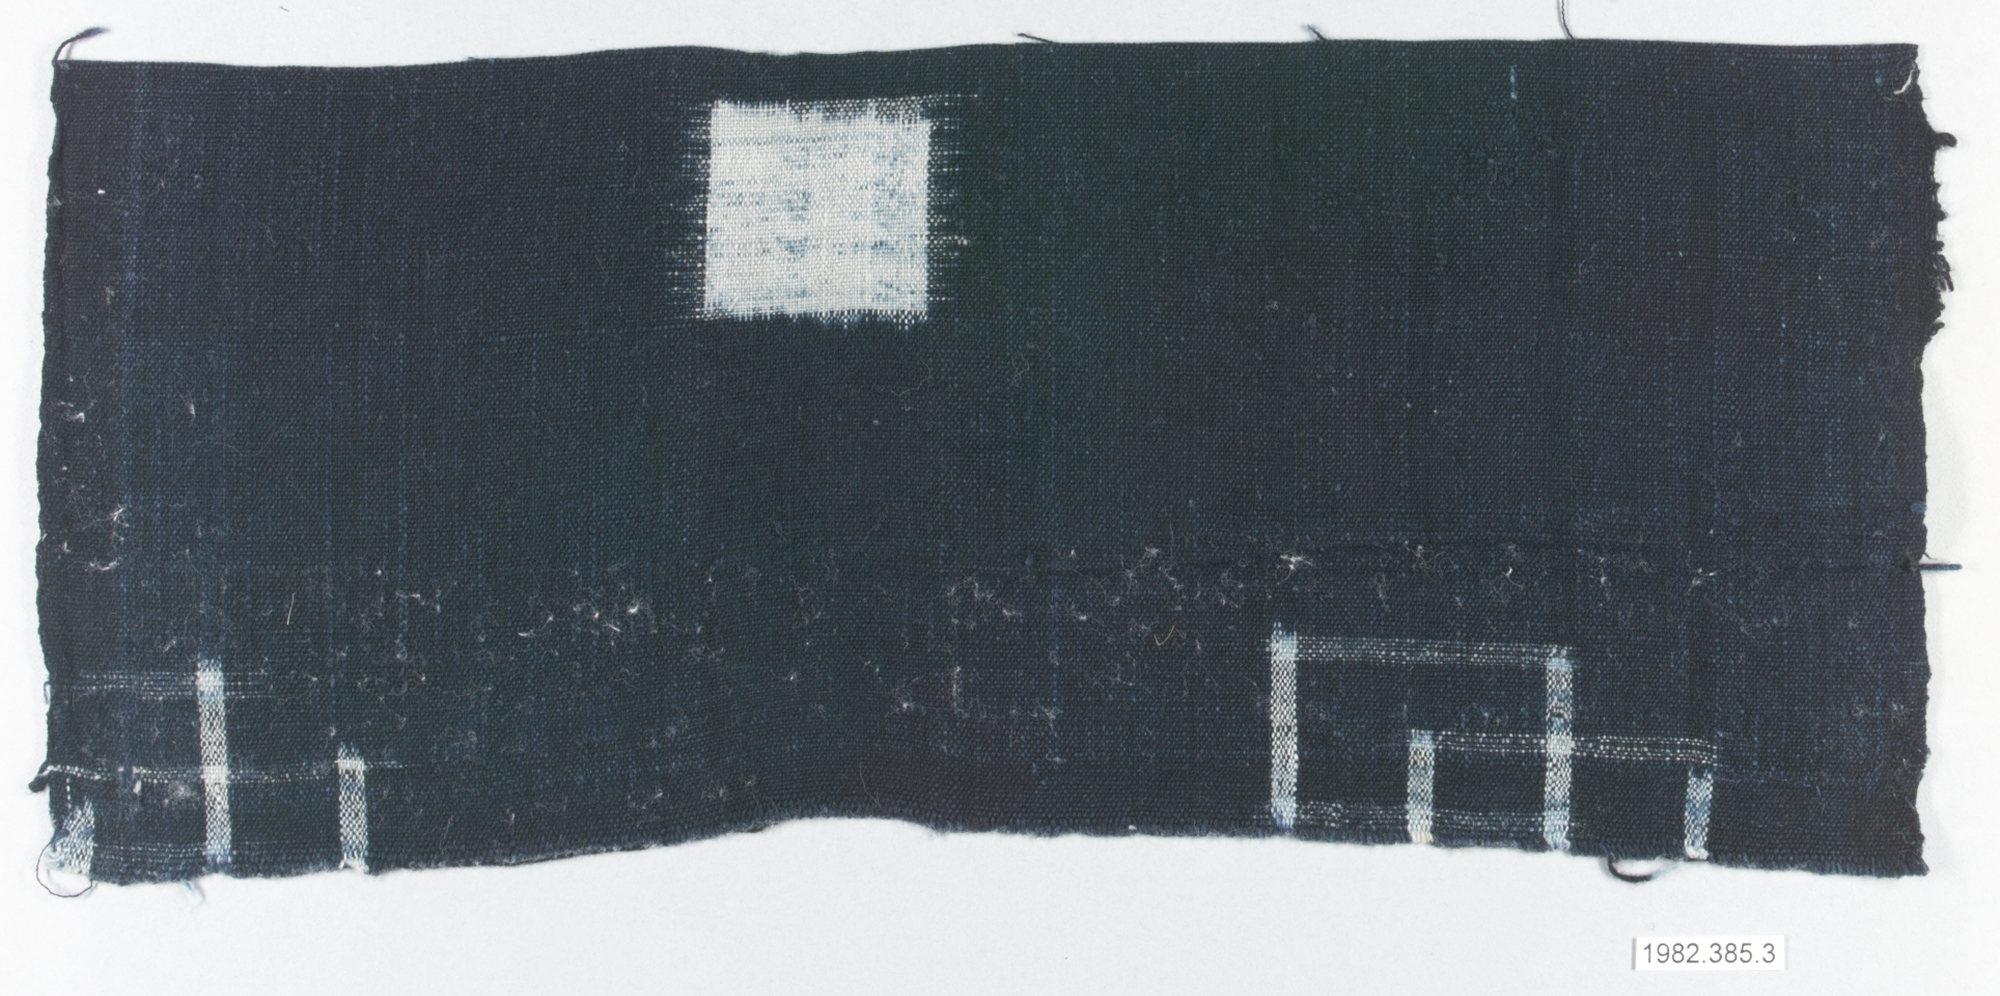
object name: piece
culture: japanese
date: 1868-1926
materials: cotton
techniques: dyeing